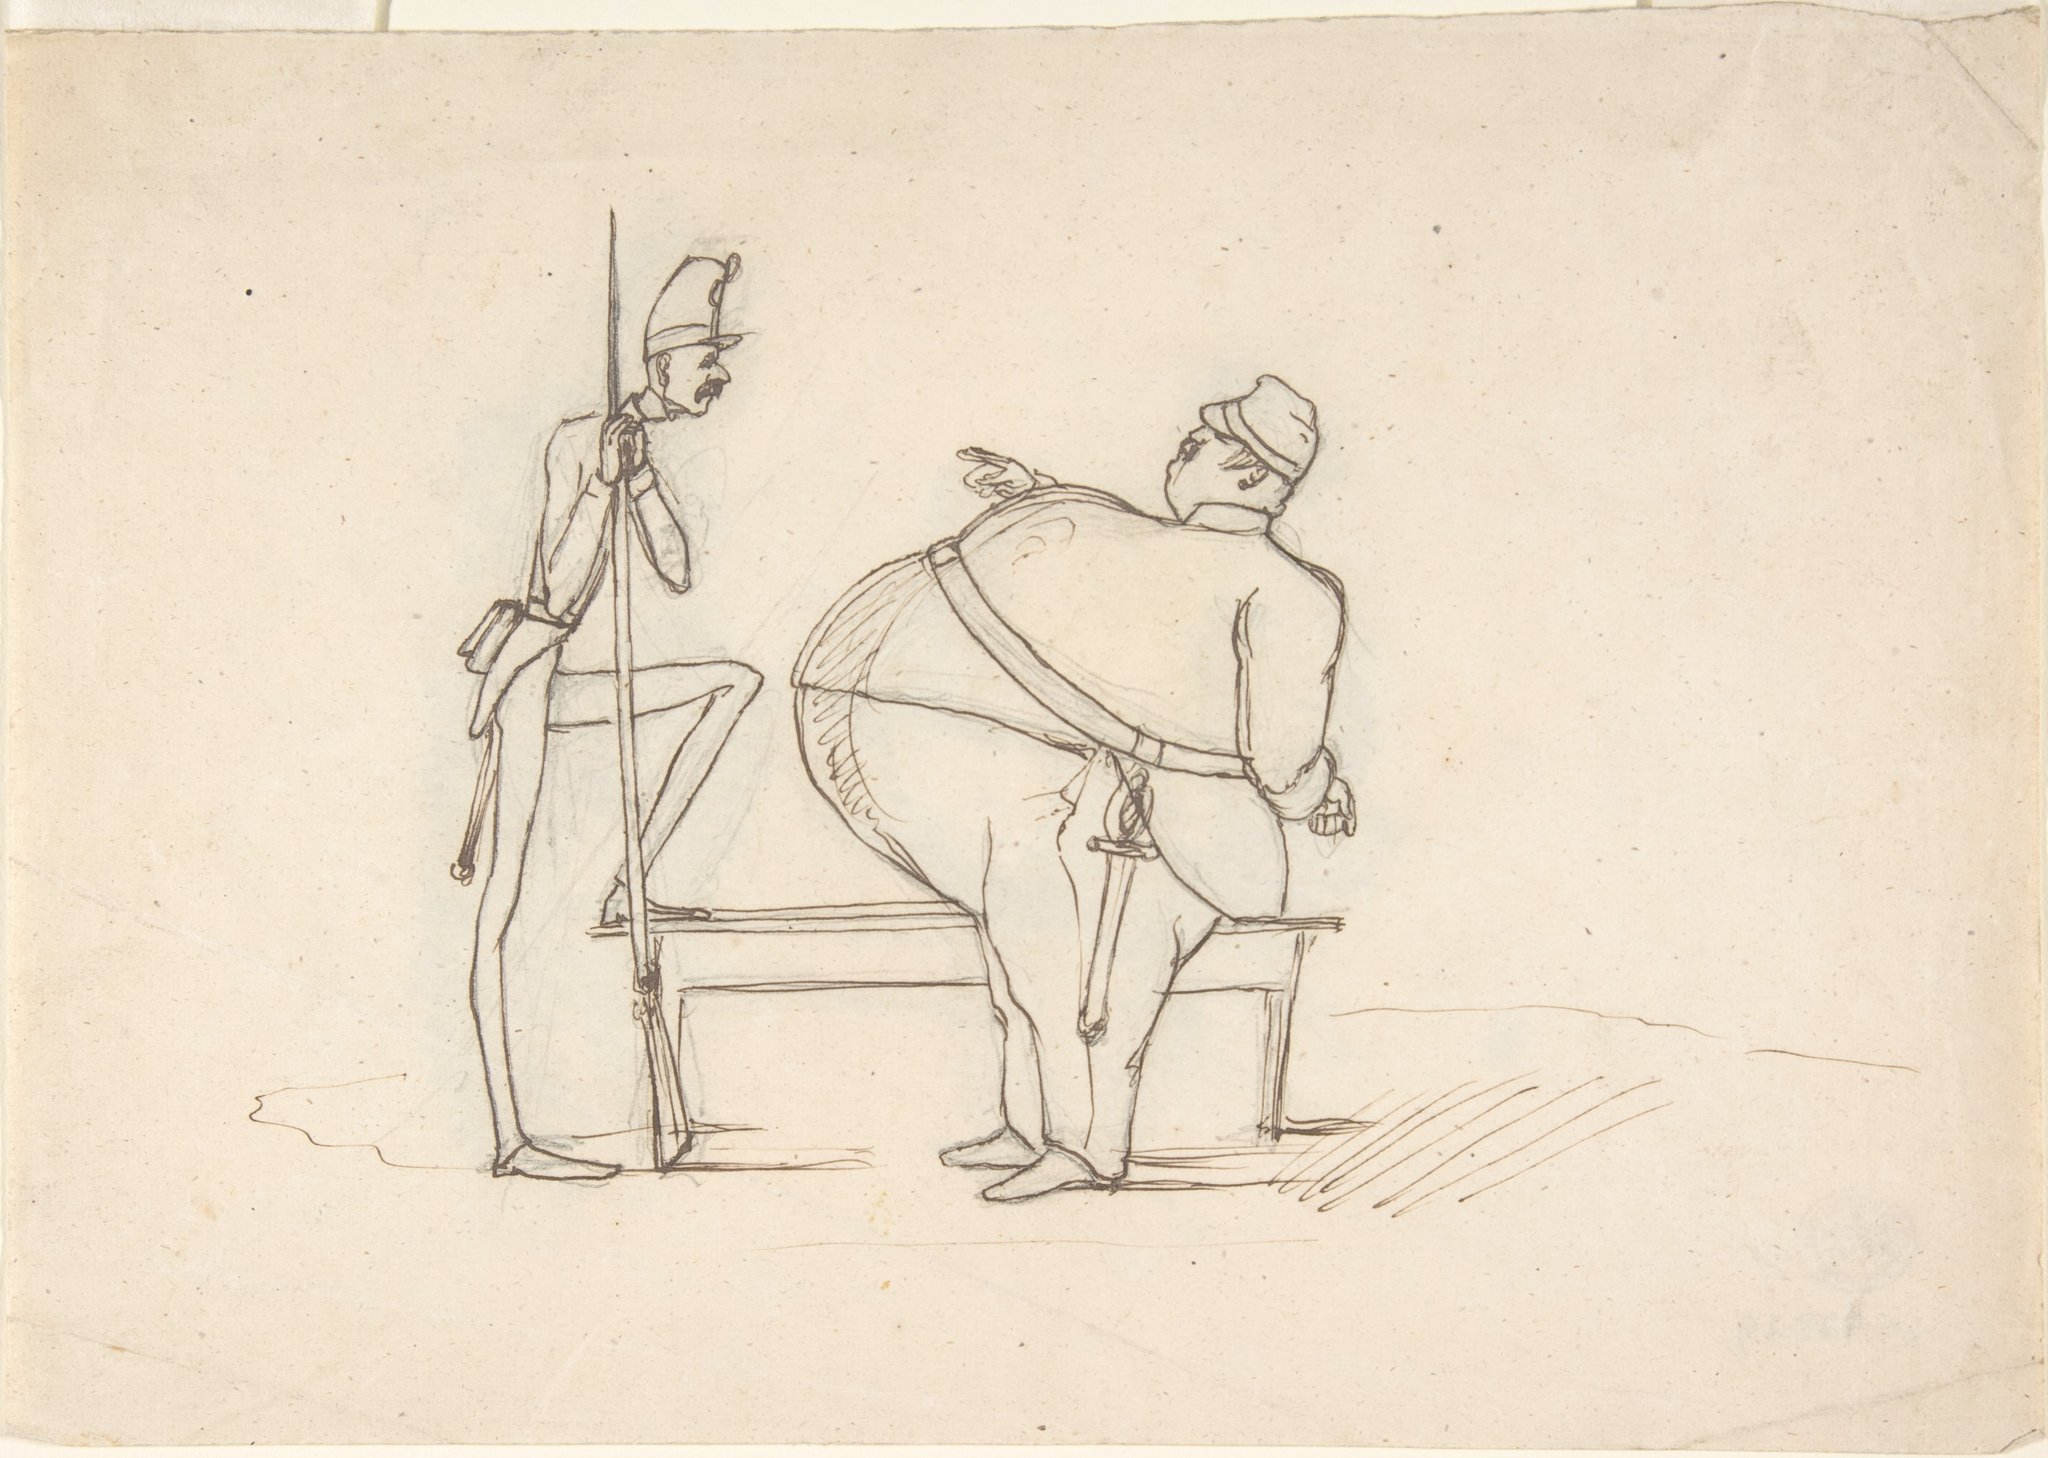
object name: drawing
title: Caricature of Two Soldiers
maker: anonymous, italian, 19th century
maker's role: artist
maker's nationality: italian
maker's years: 1800-1900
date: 1800-1900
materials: ink, pencil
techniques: pen, transfer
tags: soldiers,daggers,firearms